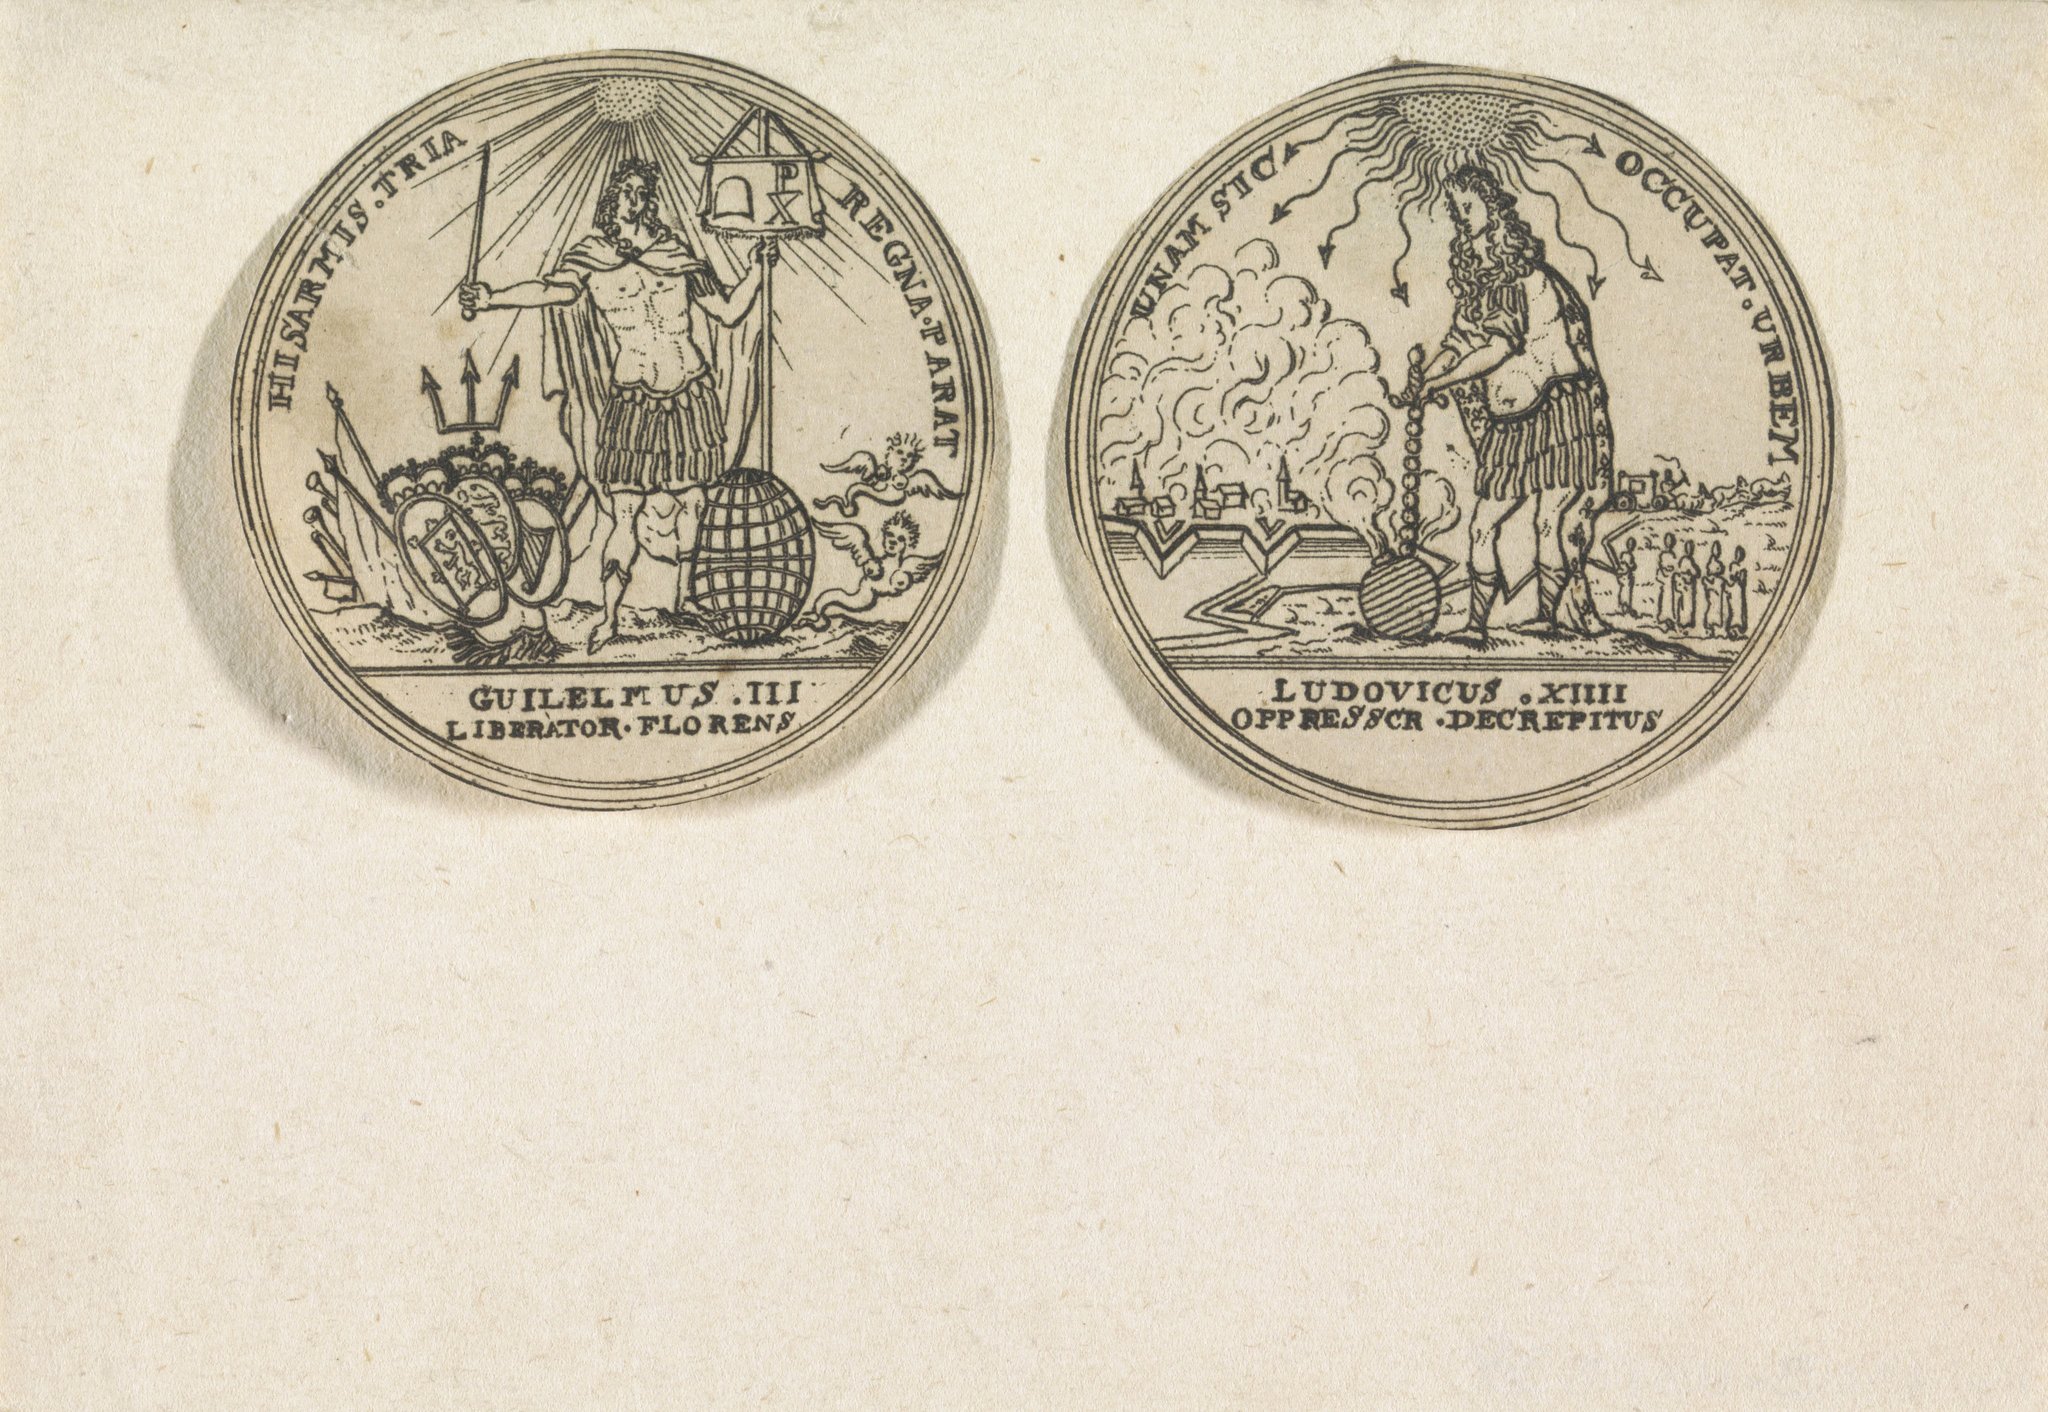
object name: print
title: Penning met portretten van Willem III, prins van Oranje, en Lodewijk XIV, koning van Frankrijk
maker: Anonymous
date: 1688-1749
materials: paper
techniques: engraving, etching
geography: low countries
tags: william iii (prince of orange and king of england, scotland, and ireland), lodewijk xiv (koning van frankrijk)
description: Portret van Willem III met een aantal allegorische objecten in een cirkel met randschrift links. Lodewijk XIV met een aantal allegorische objecten in een cirkel met randschrift rechts.